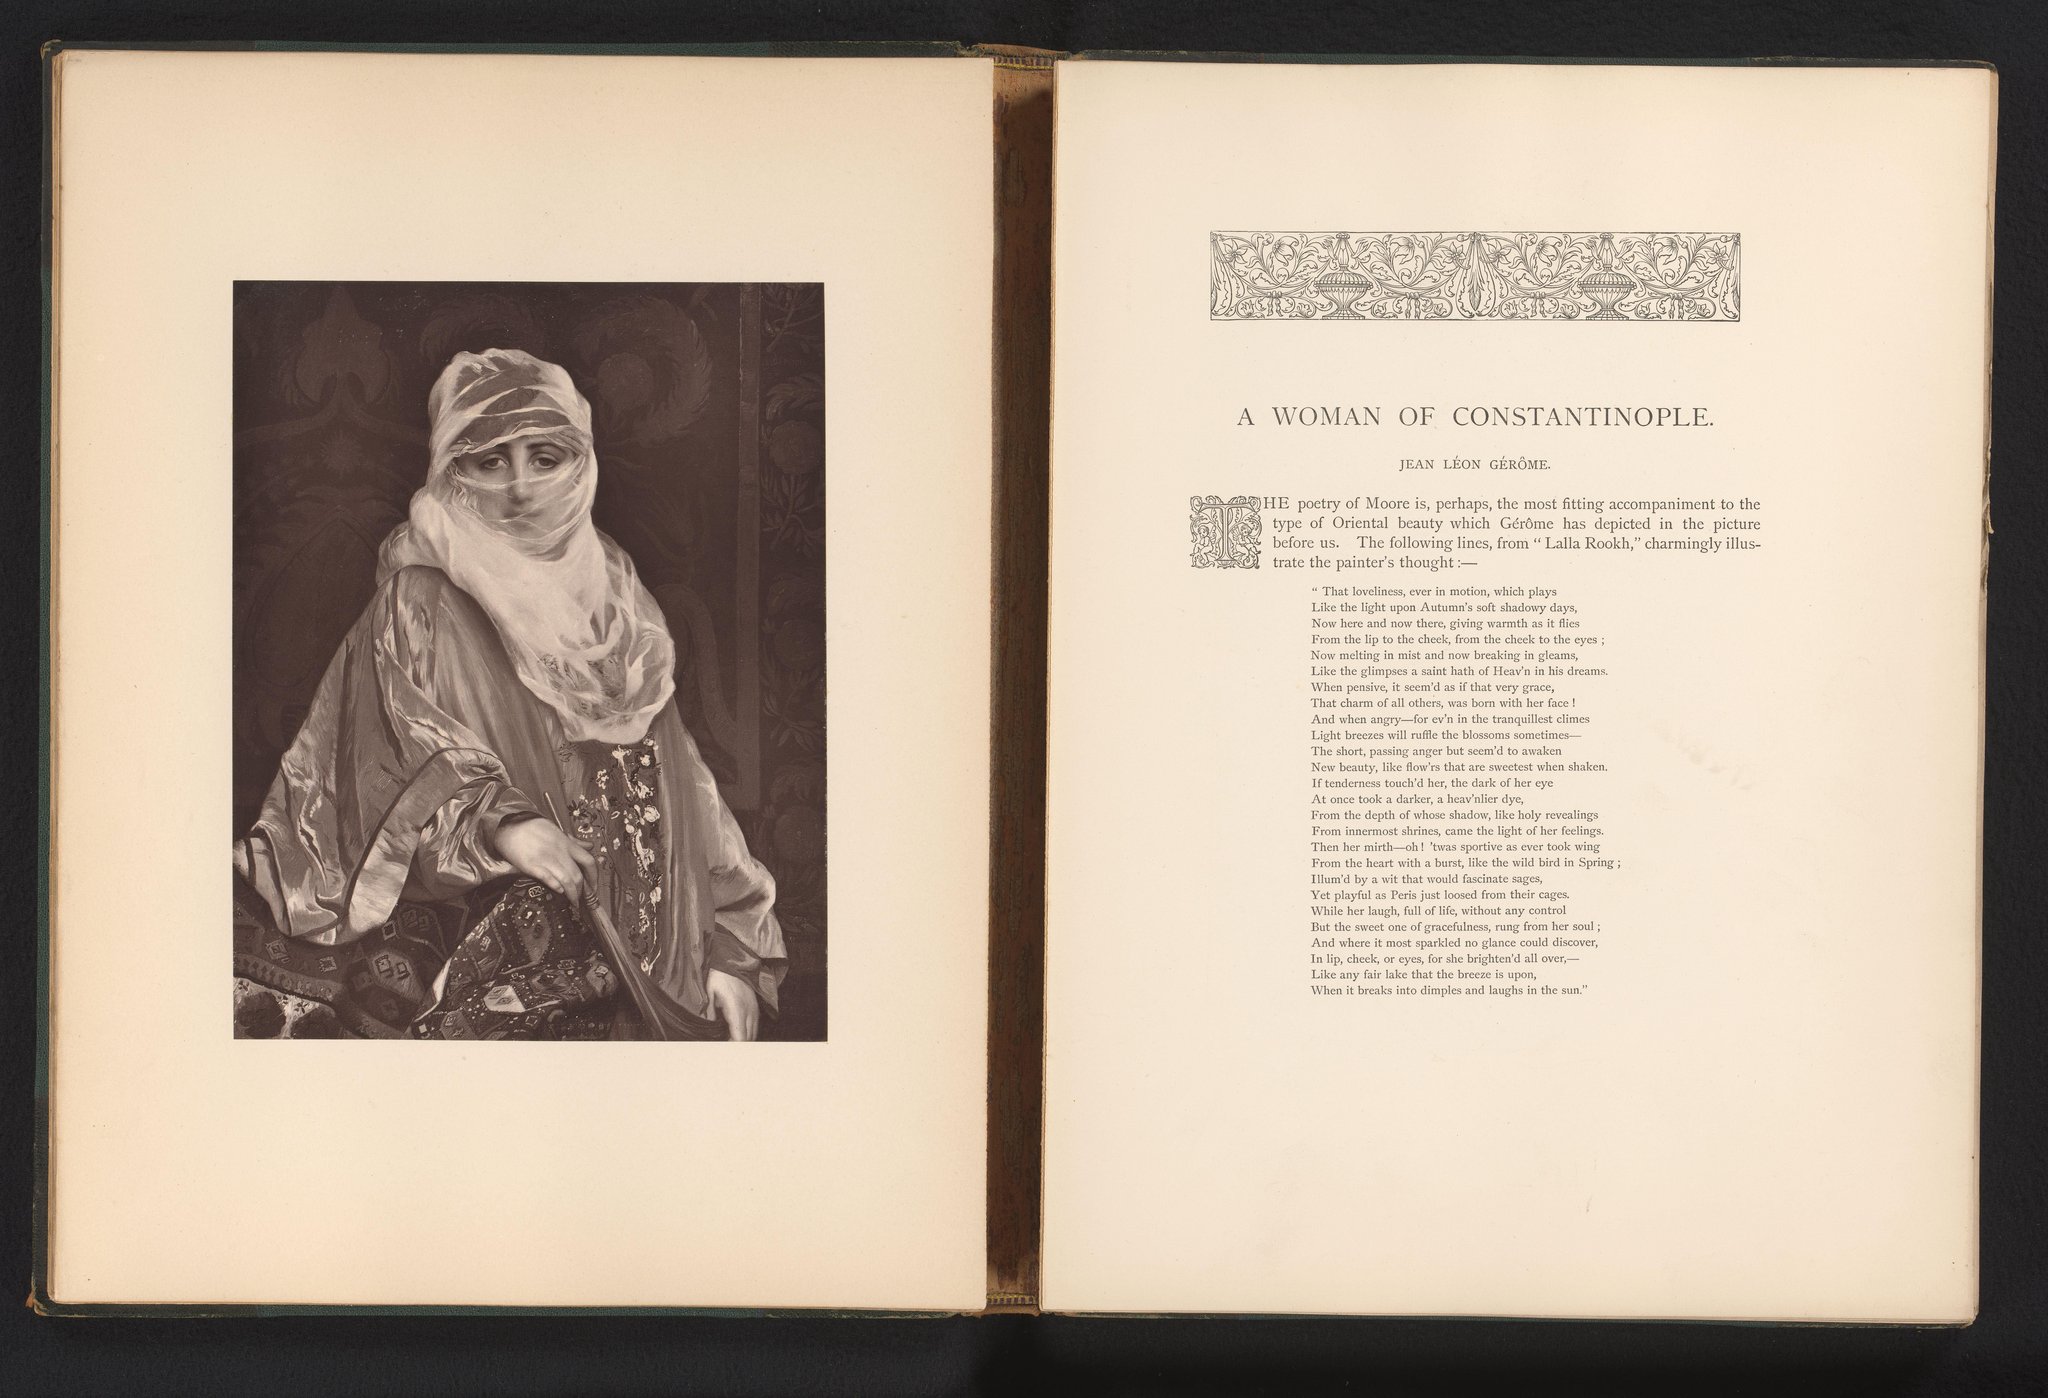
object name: photomechanical print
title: Reproductie van een portret van een Turkse vrouw door Jean-Léon Gérôme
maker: Anonymous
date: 1874-1879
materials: paper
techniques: woodburytype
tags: adolescent, young woman, maiden, historical persons